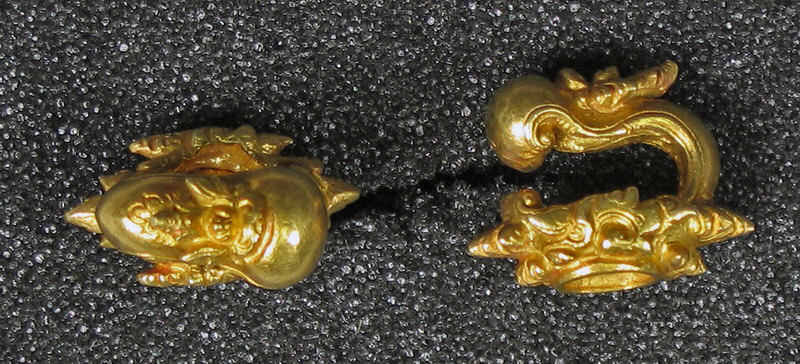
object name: pair of earring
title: Pair of Earrings, Oval Gem Settings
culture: indonesian, central java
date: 701-1200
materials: gold